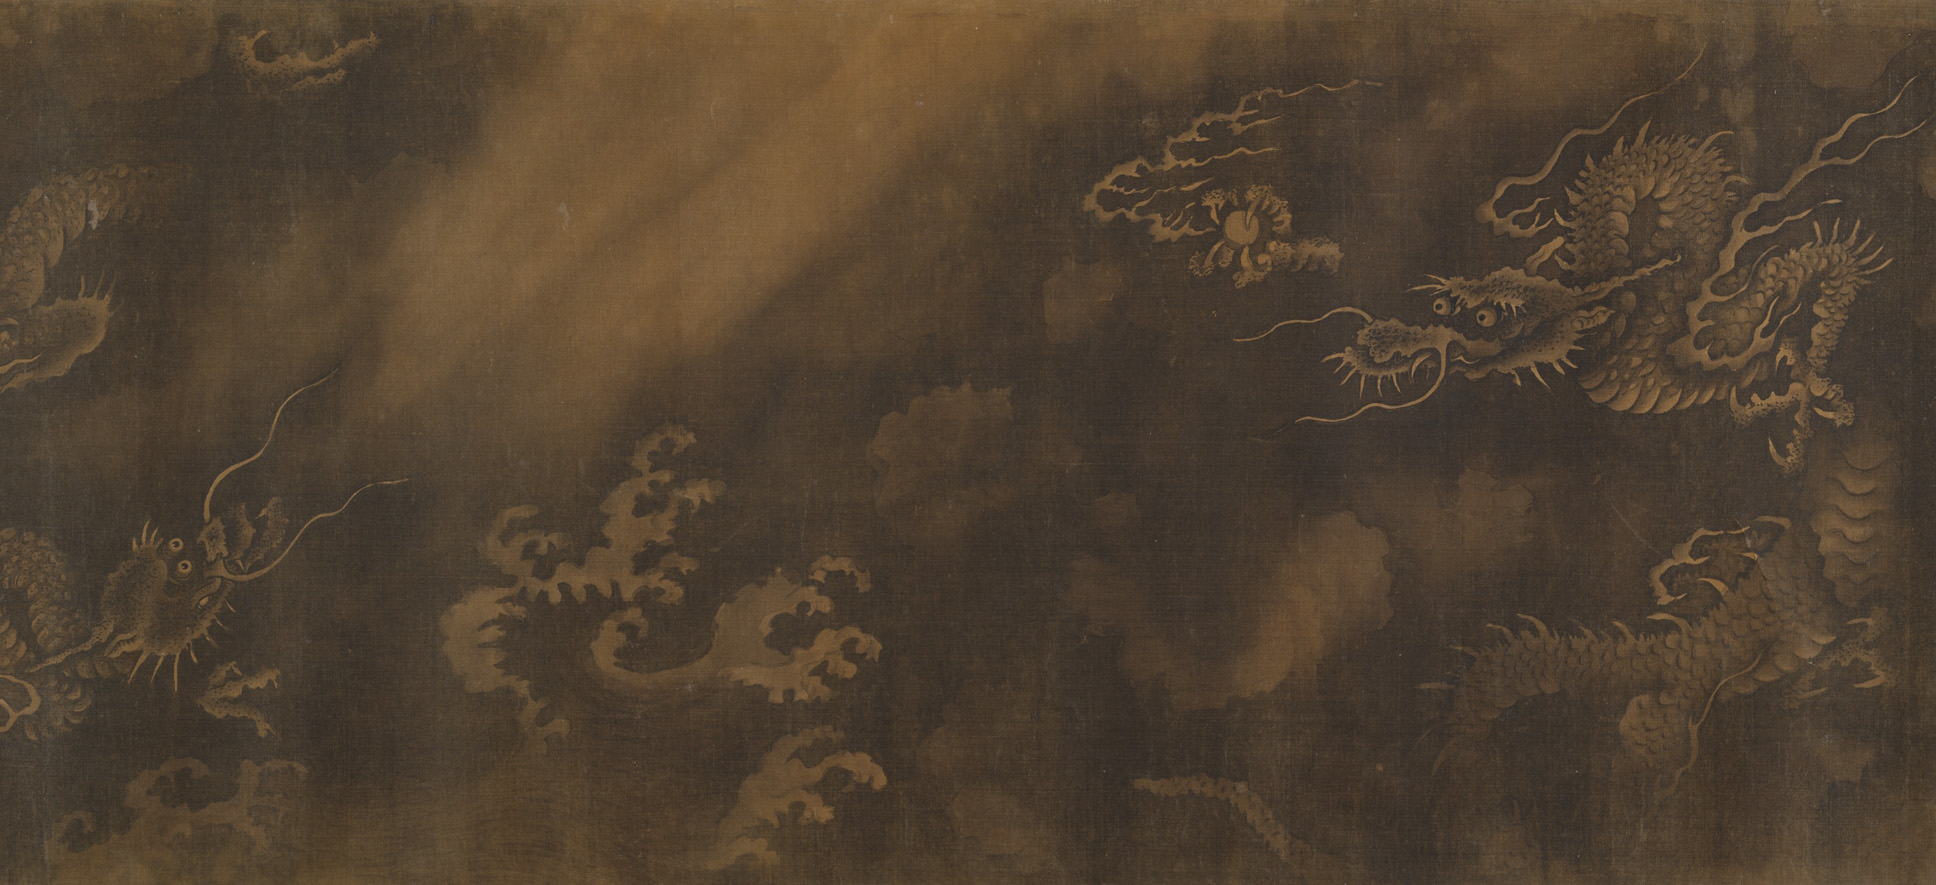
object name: handscroll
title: Beneficent Rain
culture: chinese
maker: zhang yucai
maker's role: artist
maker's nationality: chinese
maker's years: -1316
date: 1267-1333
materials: ink, silk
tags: dragons